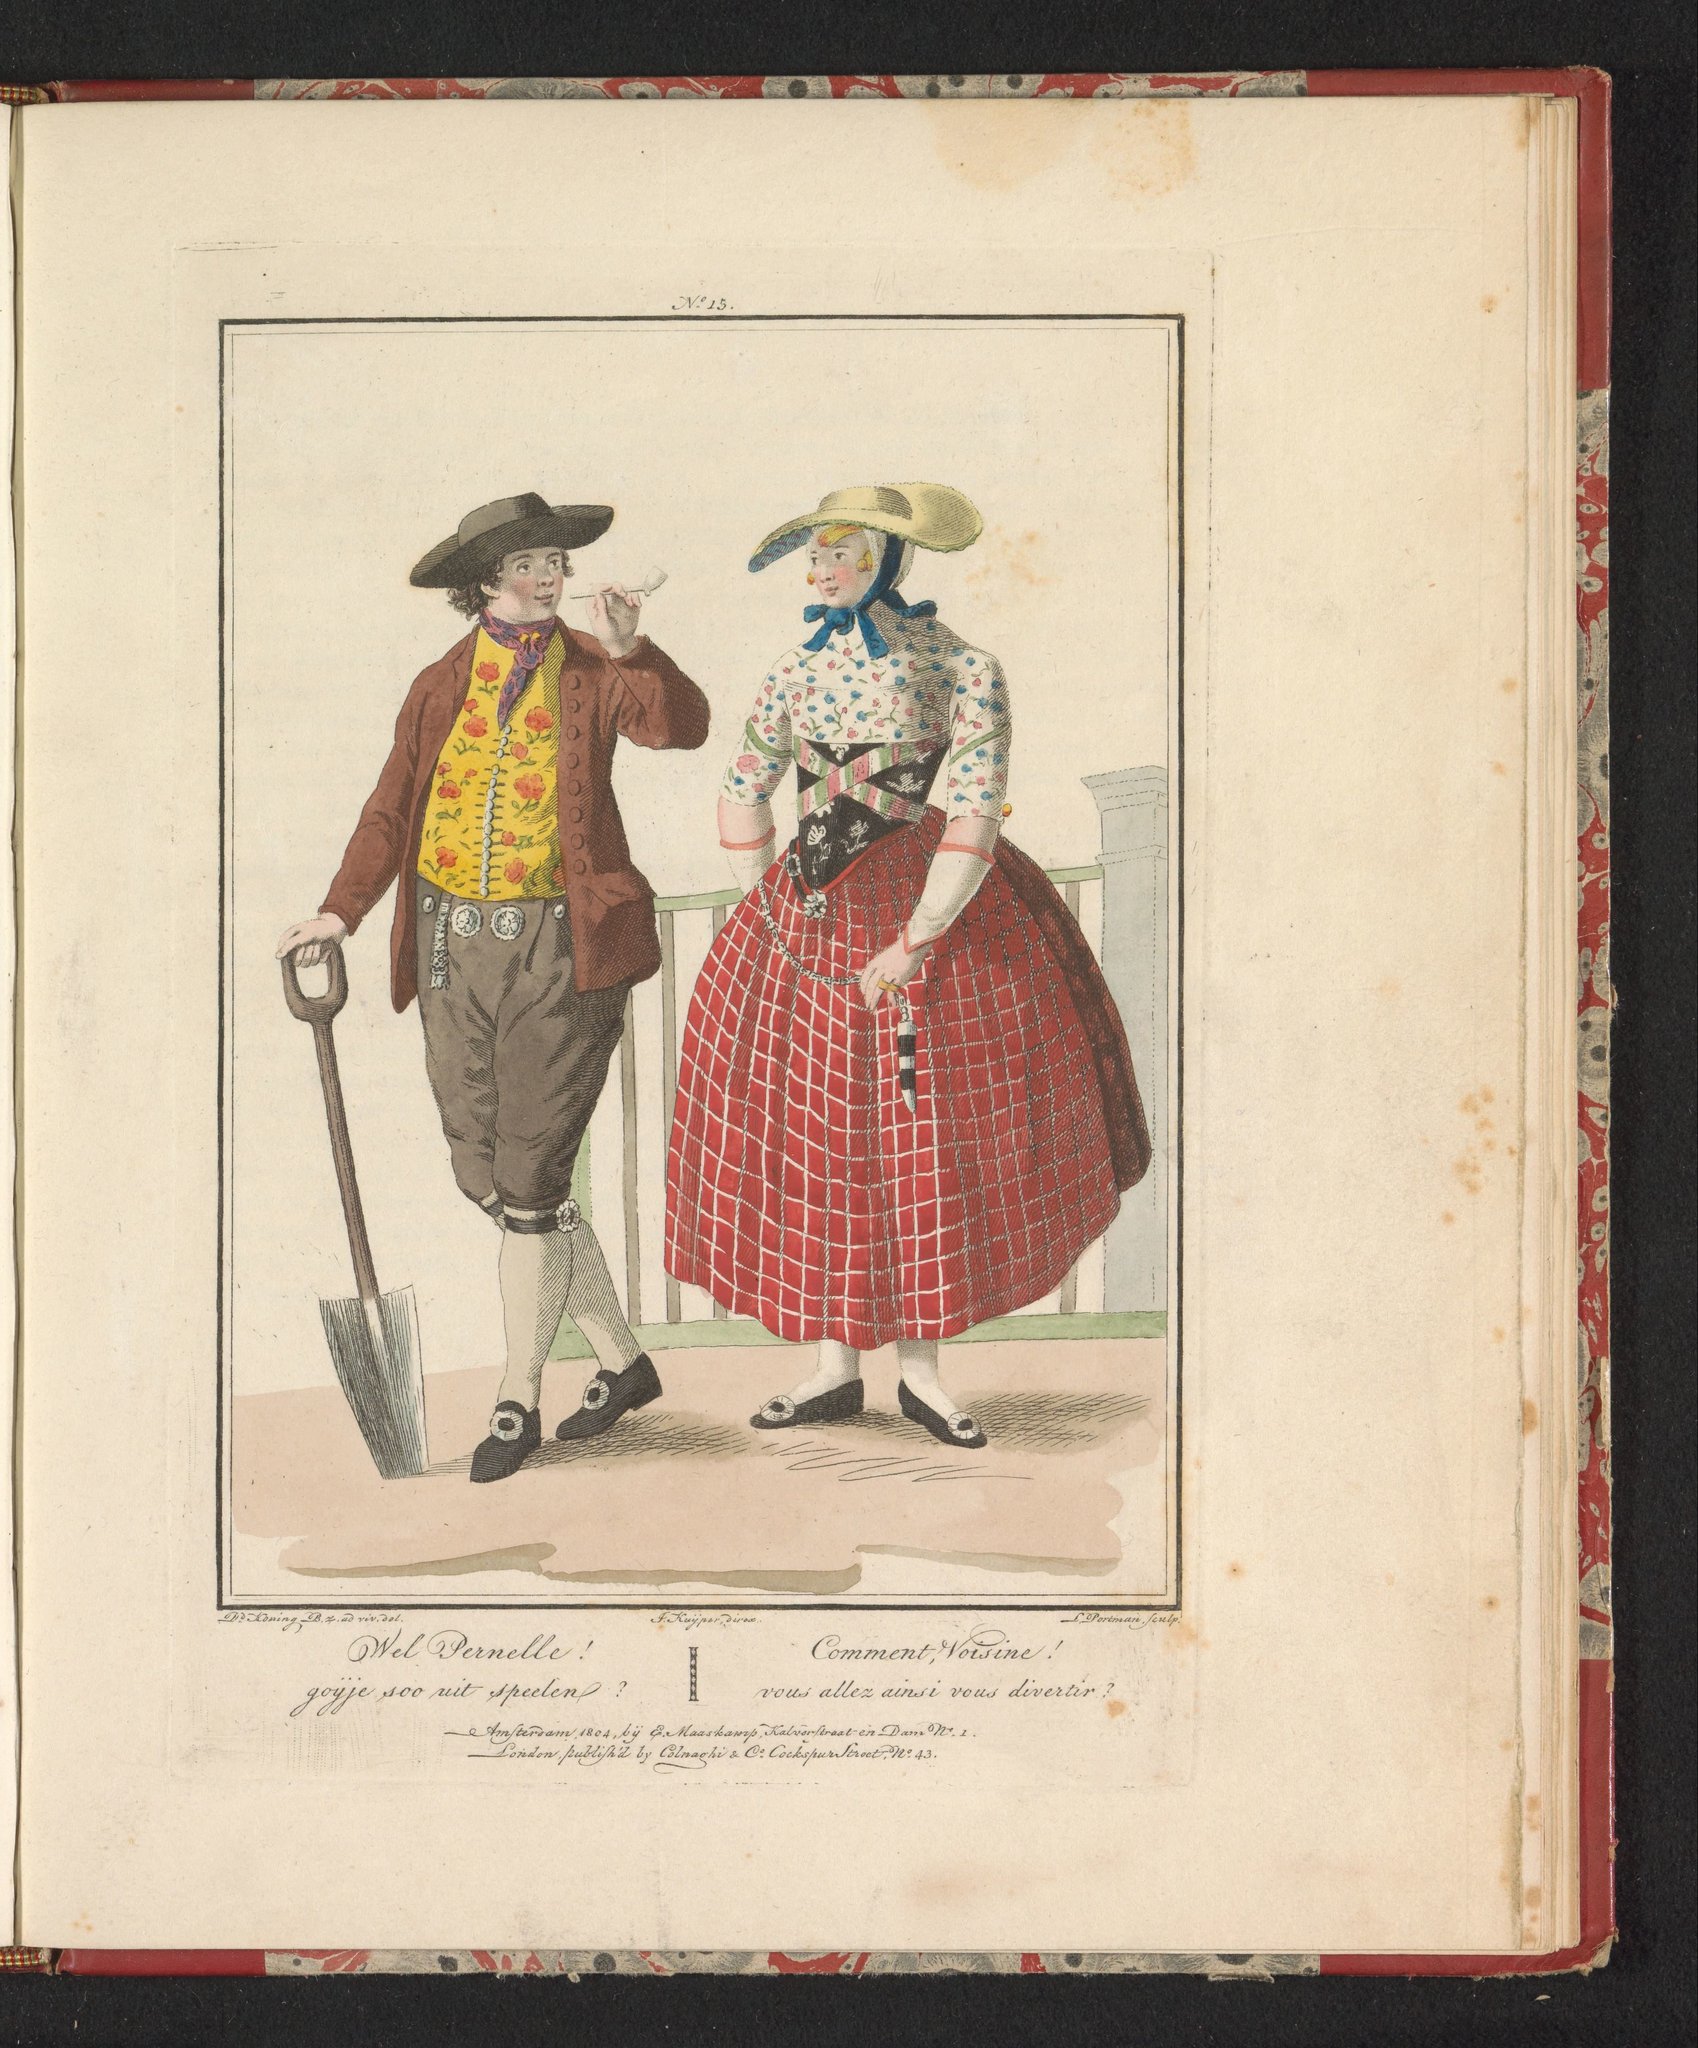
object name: print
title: Man en vrouw van Zuid-Beveland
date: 1804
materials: paper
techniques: etching, hand coloring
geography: netherlands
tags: folk costume, regional costume, clothes, costume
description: Man en vrouw in klederdracht van het Zeeuwse eiland Zuid-Beveland. De boer met een spade in de hand, en vrouw draagt een wijde rode rok. Vierde aflevering van vier platen, verschenen in 1805. Onderdeel van een gebonden uitgave van de reeks van twintig platen van Nederlandse klederdrachten in de Bataafse Republiek aan het begin van de negentiende eeuw door Maaskamp, ca. 1807.